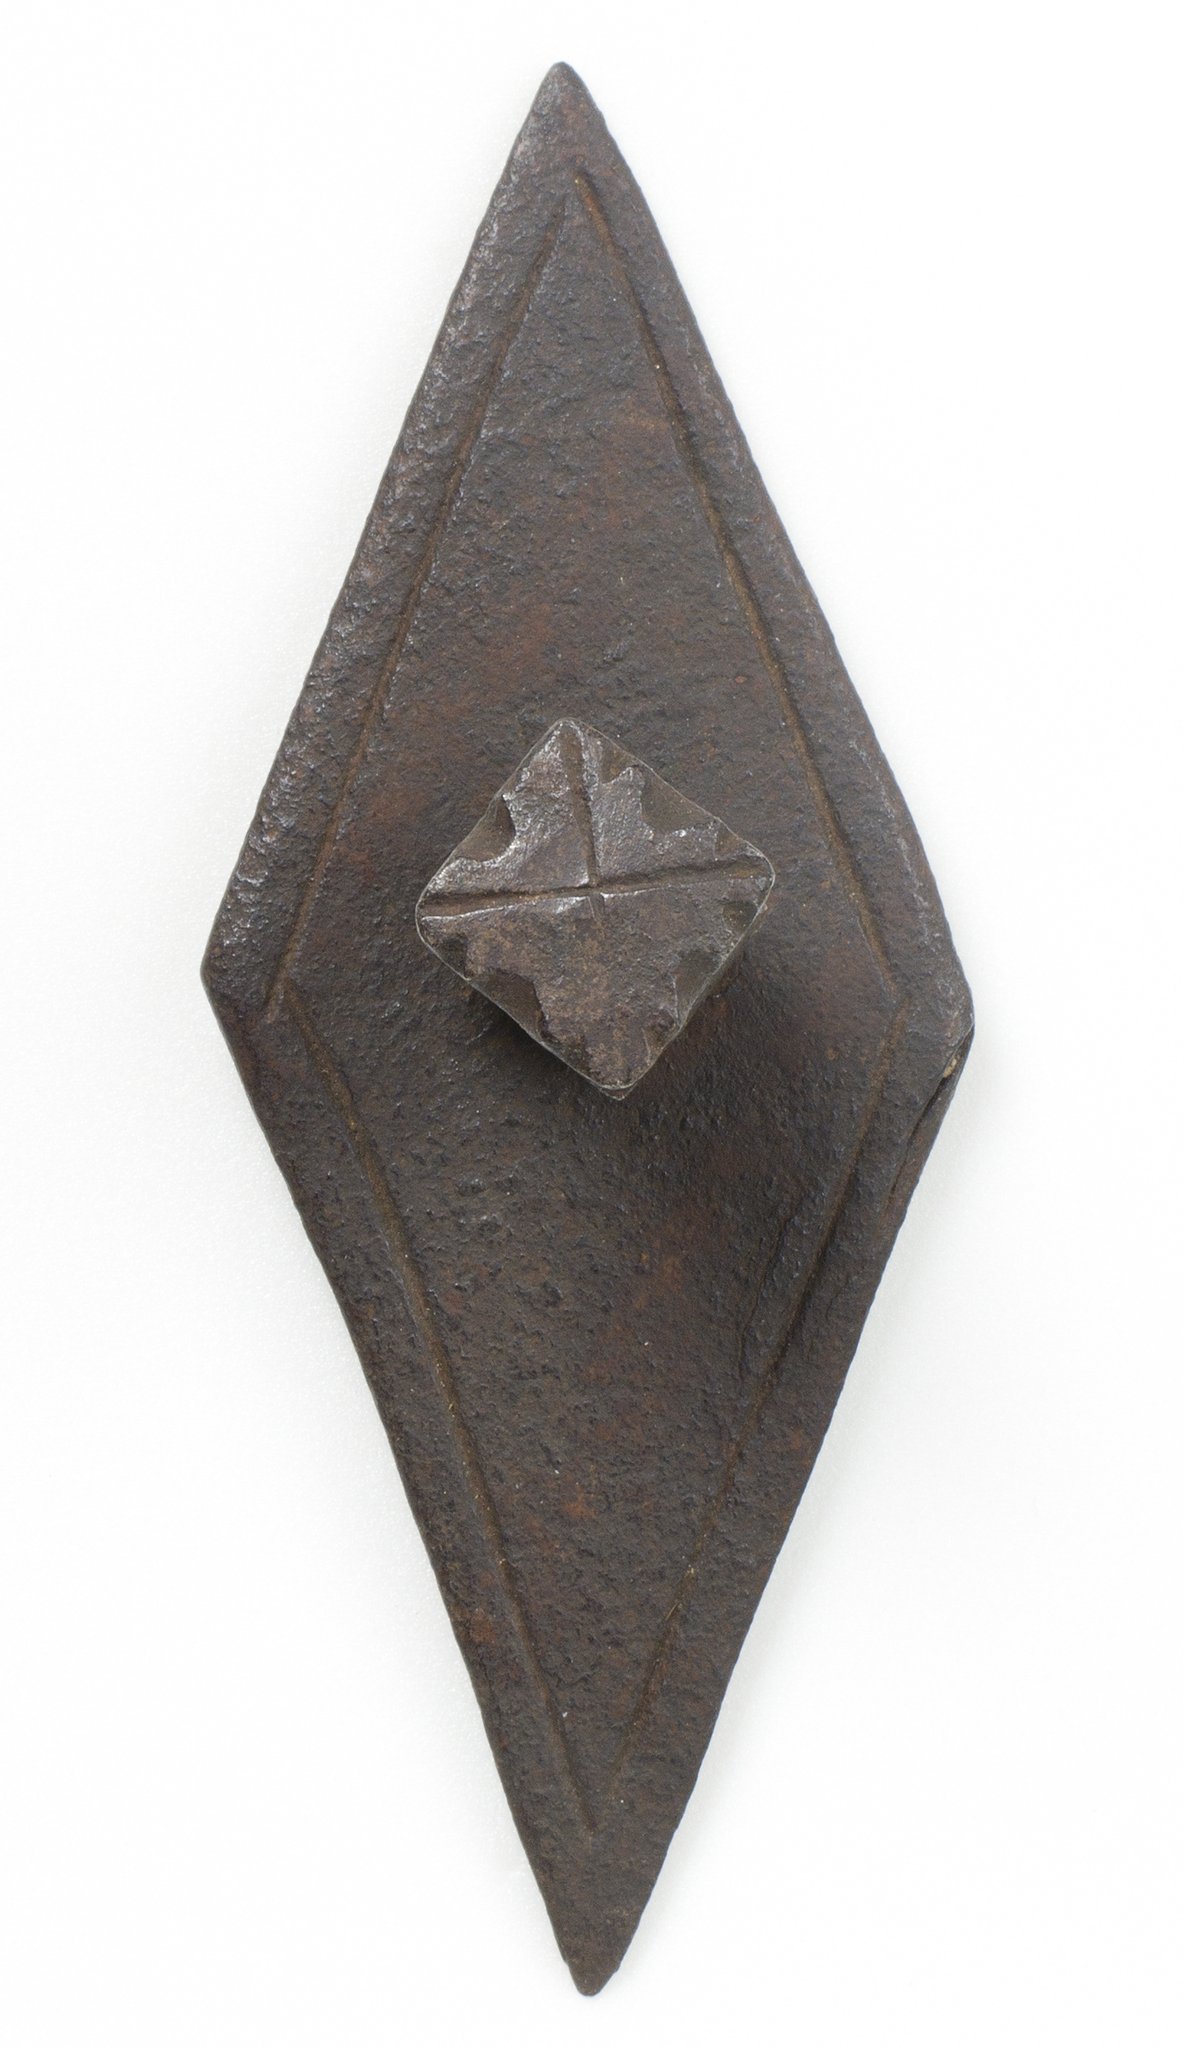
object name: plate and nail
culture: european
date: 1401-1600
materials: iron